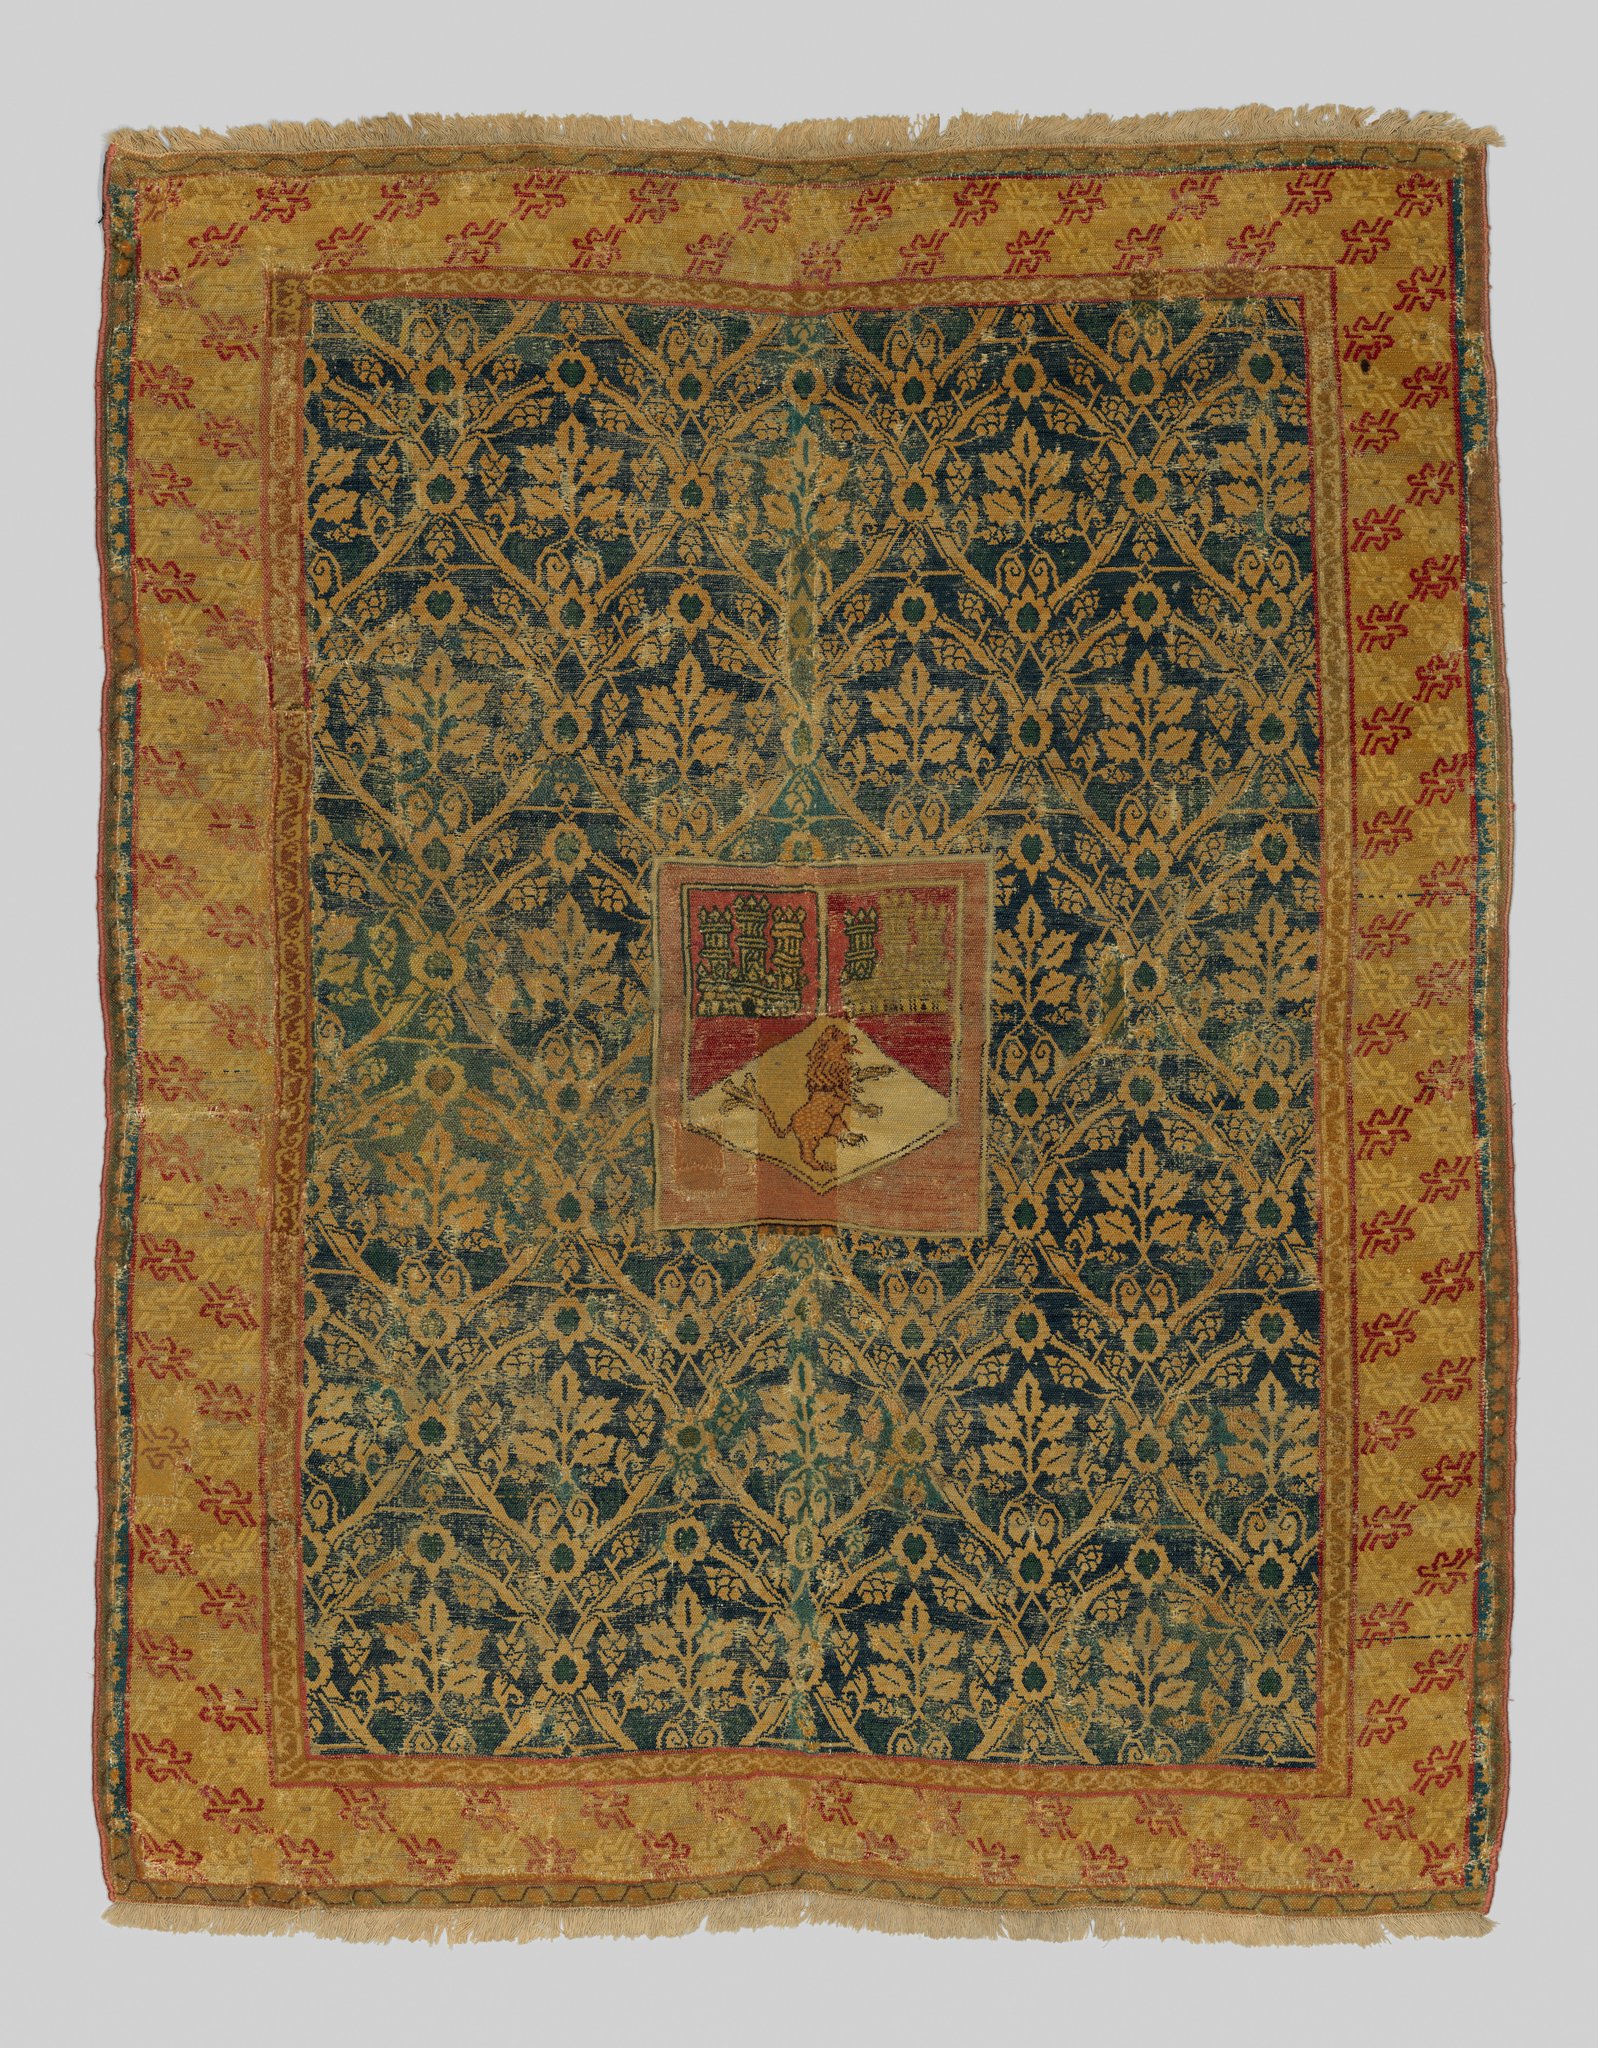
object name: carpet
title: Carpet with Coat of Arms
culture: spanish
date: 1401-1600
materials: wool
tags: coat of arms